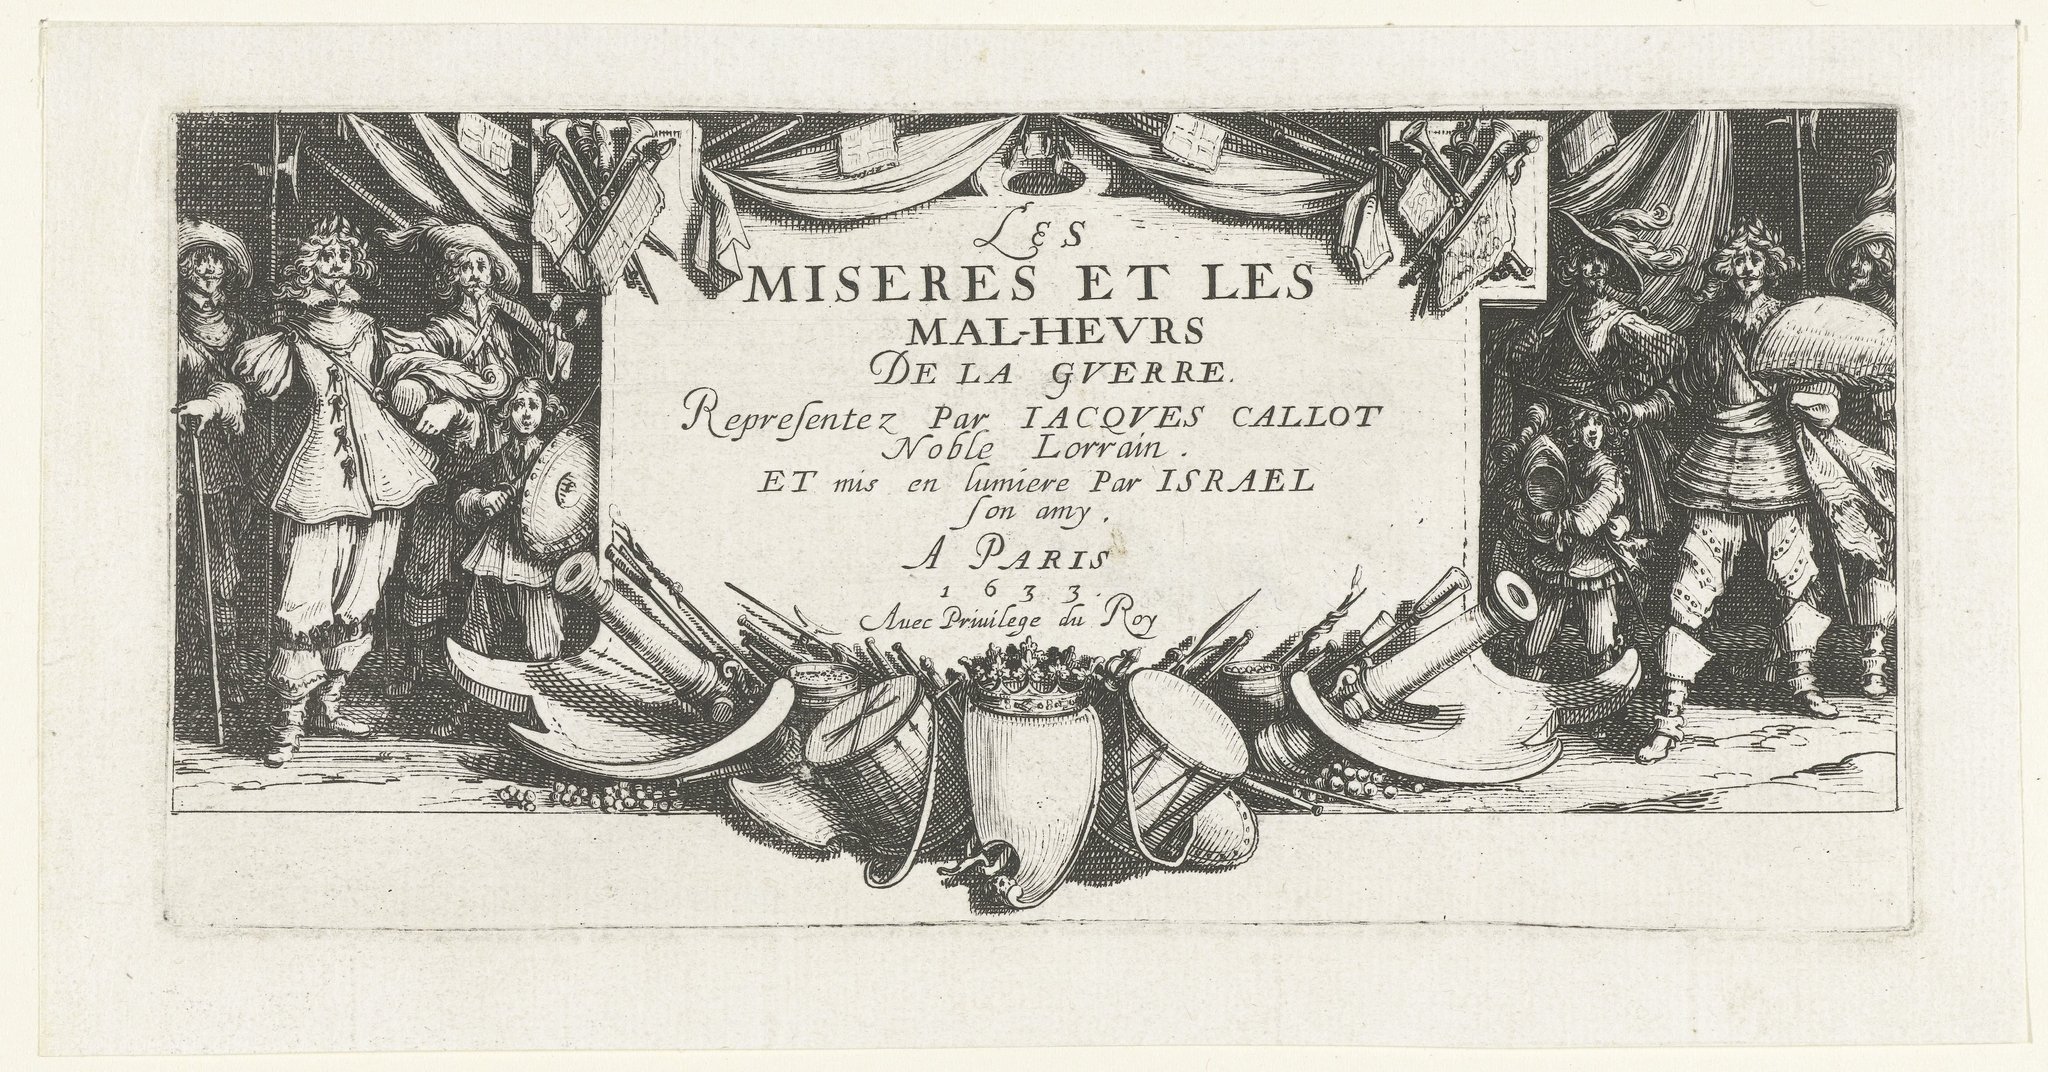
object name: print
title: Les miseres et les malheurs de la guerre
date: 1633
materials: paper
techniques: etching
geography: nancy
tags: crown (symbol of sovereignty), drum (musical instrument), weapons, firearms: cannon, officer, ornament ~ cartouche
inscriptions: collector's mark: Lugt 240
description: Franse tekst in cartouche in de vorm van een groot tablet. Op de voorgrond wapens, kogels, trommels en een kroon. Aan weerszijden van het tablet soldaten. Onder de voorstelling een lege marge. Dit is de titelprent voor een serie van 17 prenten met voorstellingen van diverse soorten ellende die oorlogvoering met zich meebrengt.